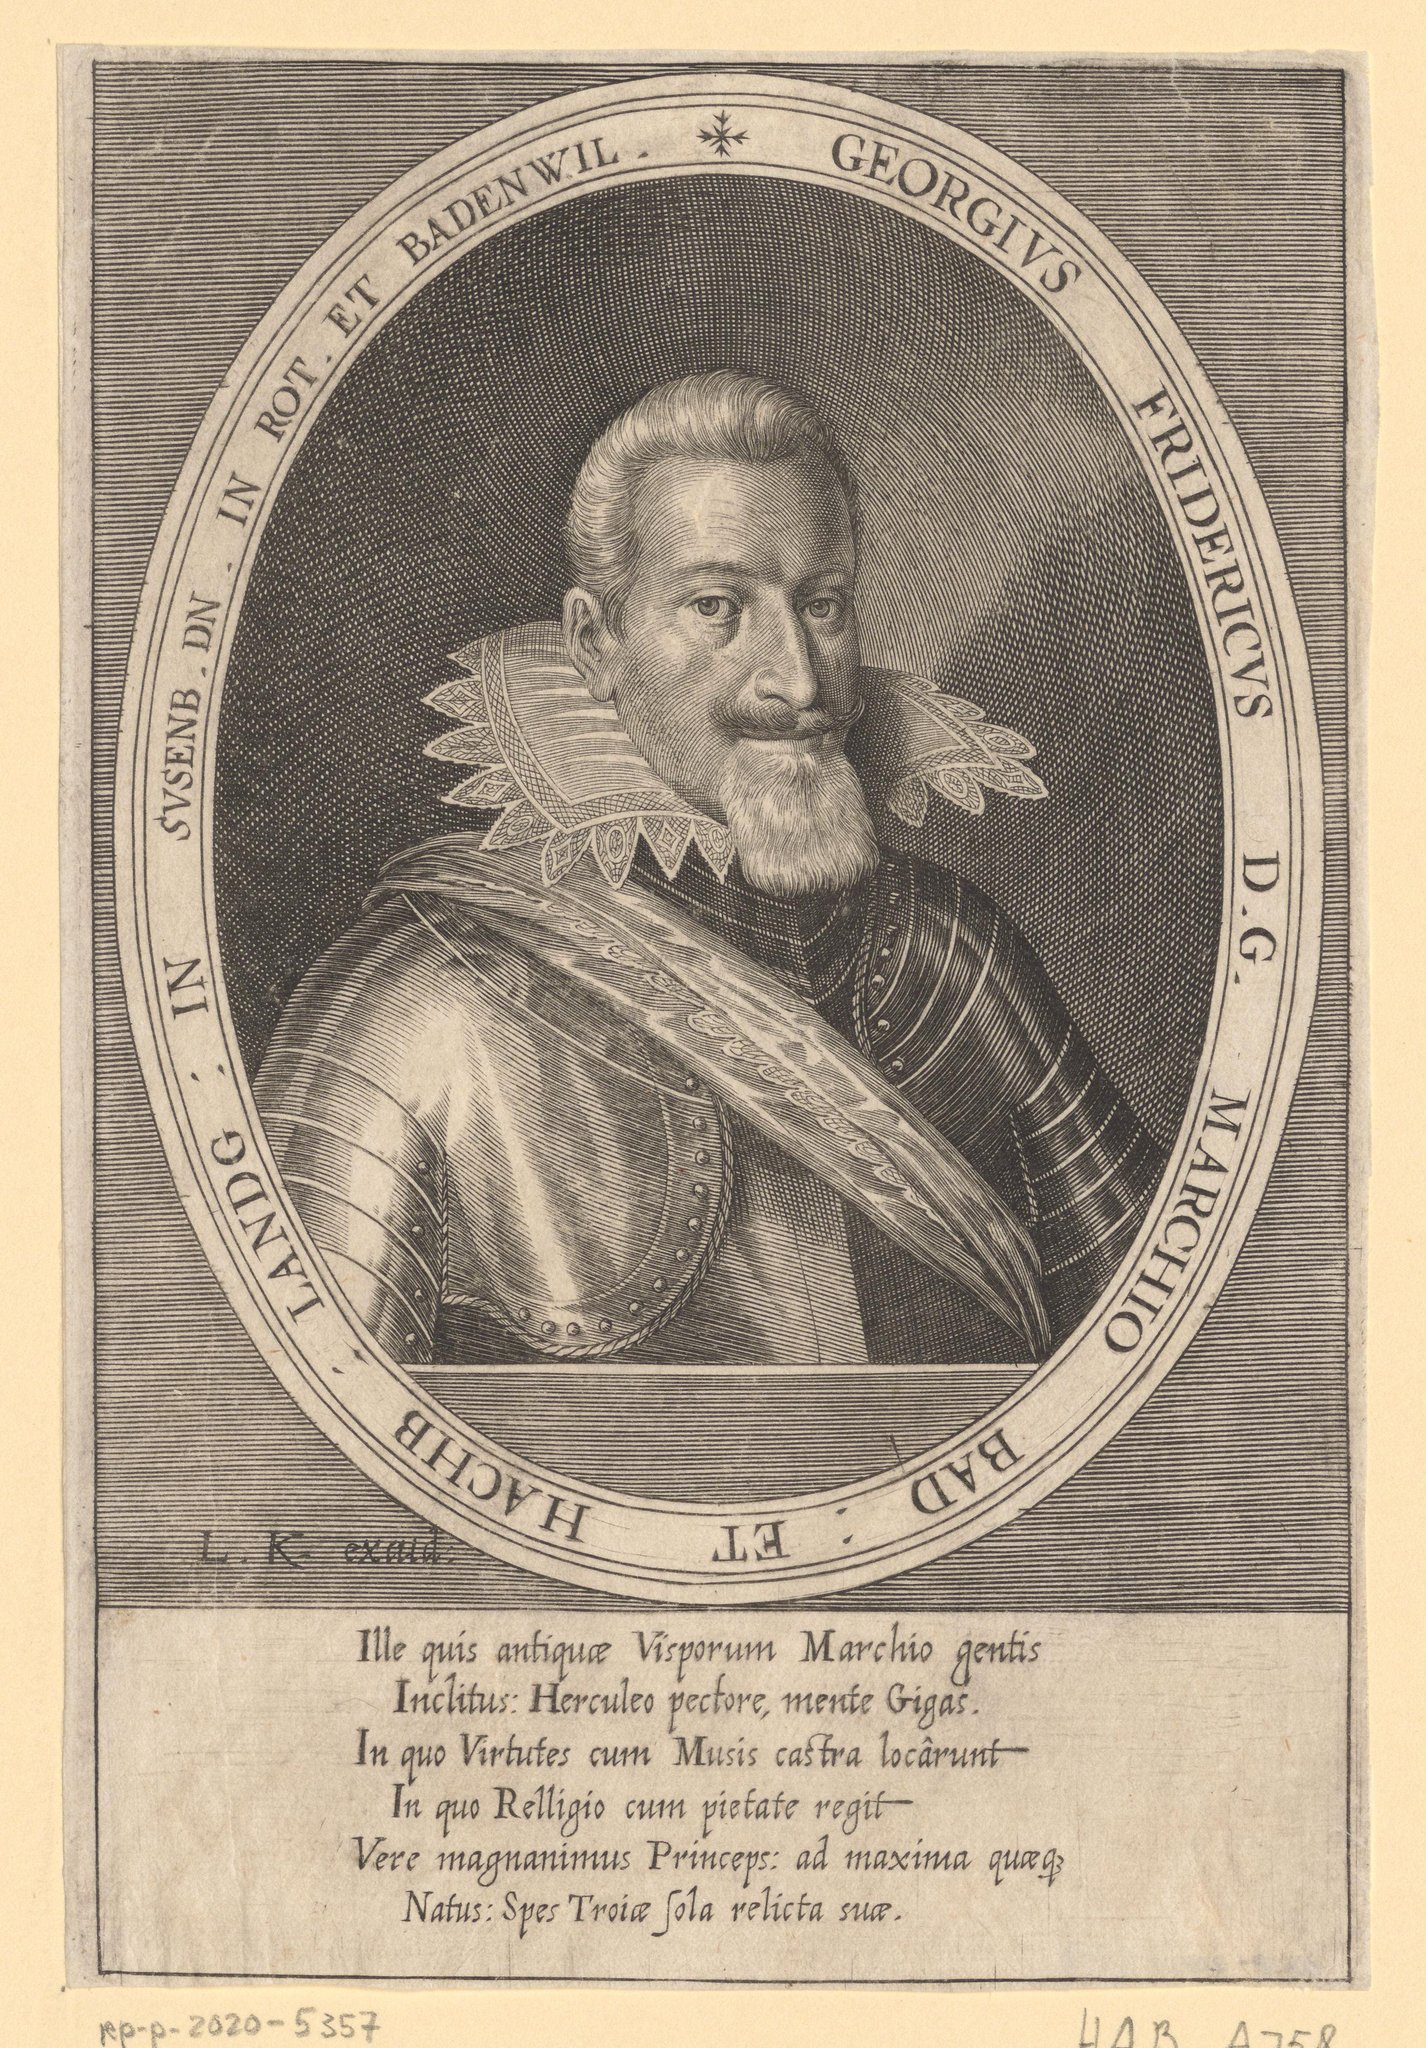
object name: print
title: Portret van Georg Friedrich von Baden-Durlach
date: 1598-1637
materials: paper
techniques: engraving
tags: commander-in-chief, general, marshal, historical persons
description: Zesregelig vers in het Latijn in de ondermarge en tekst in het Latijn in de omlijsting.